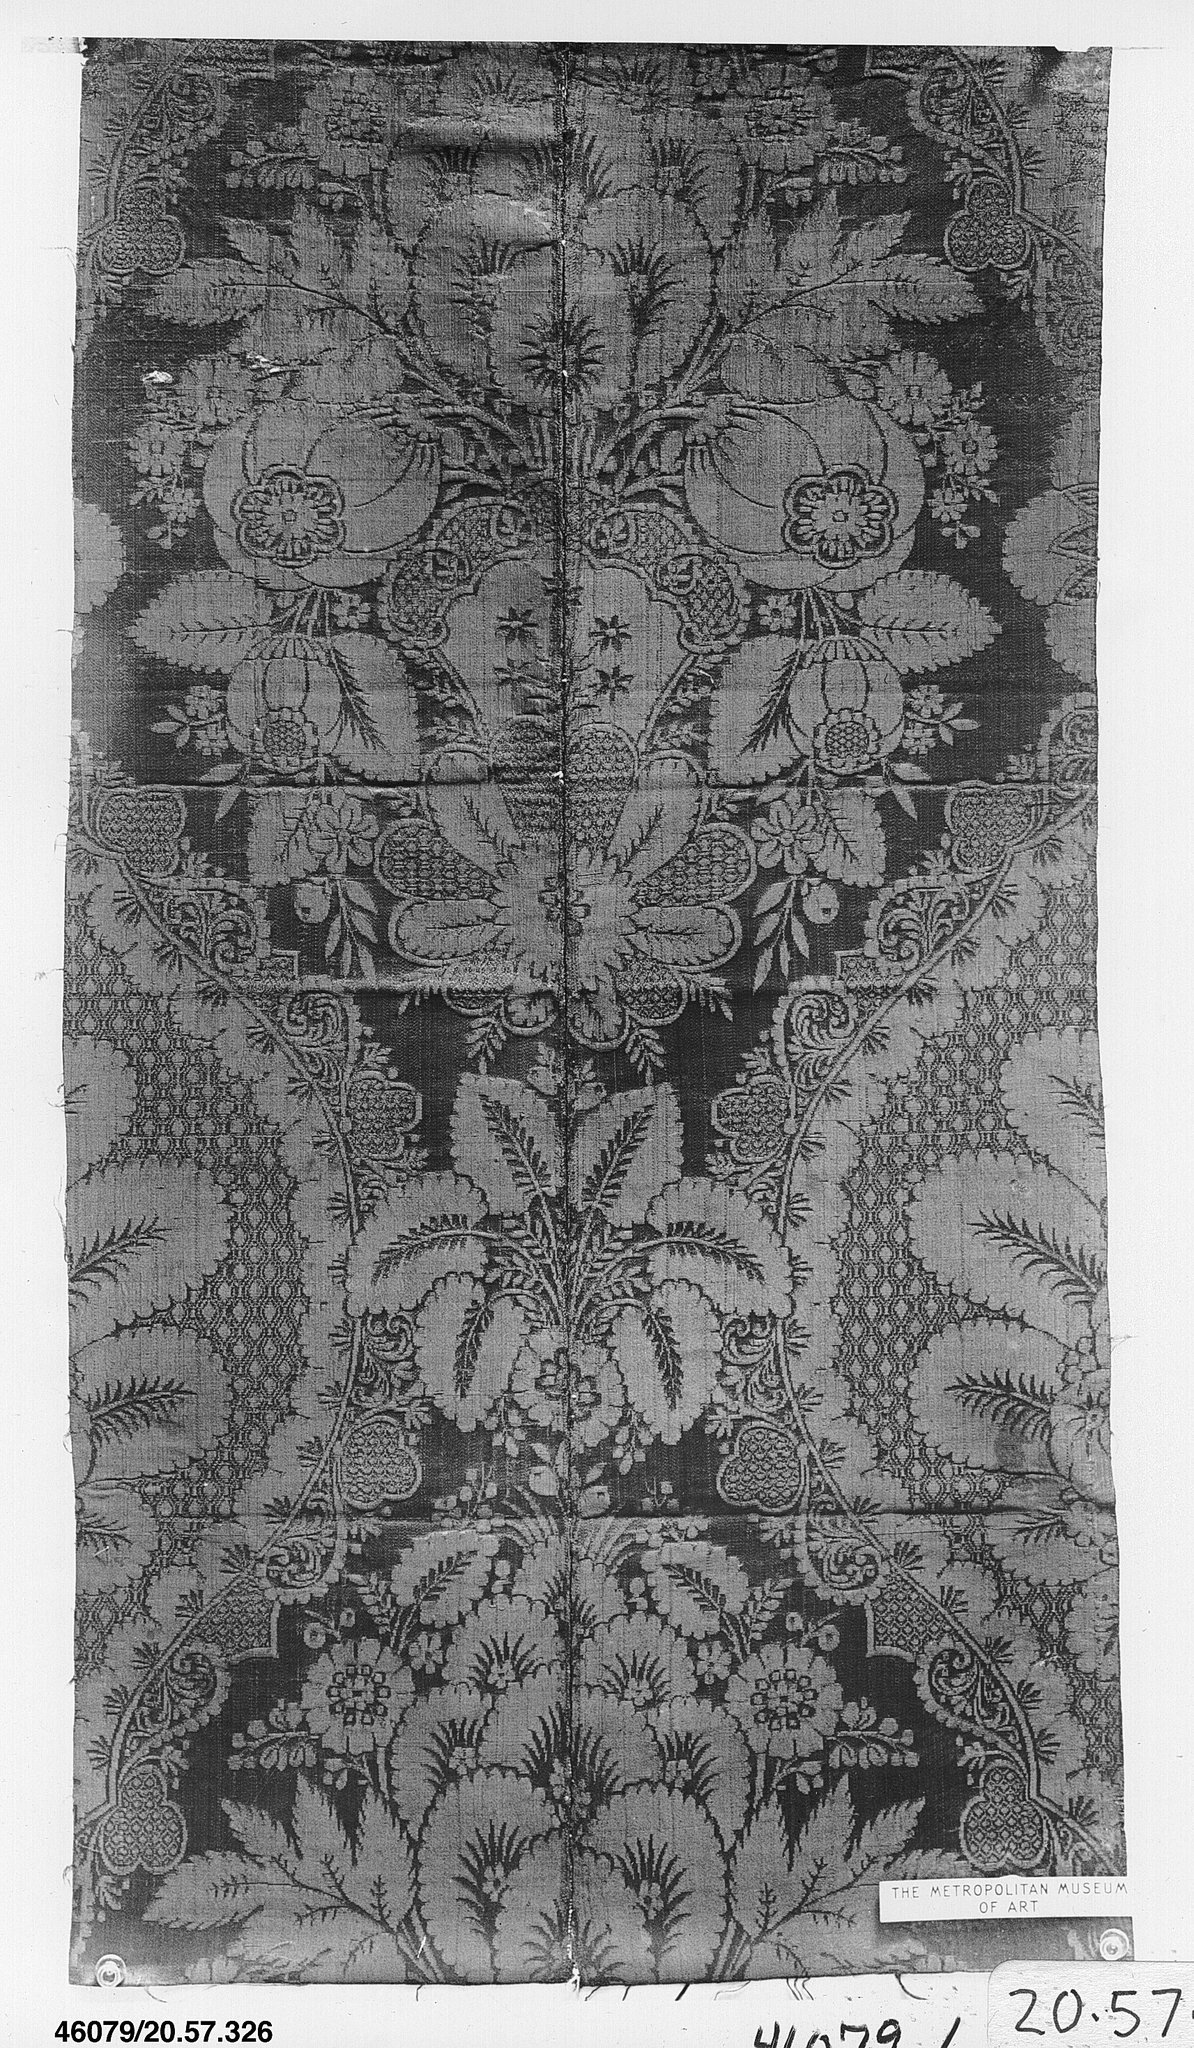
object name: piece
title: Fragment of silk damask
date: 1725-1730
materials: silk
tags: flowers,leaves